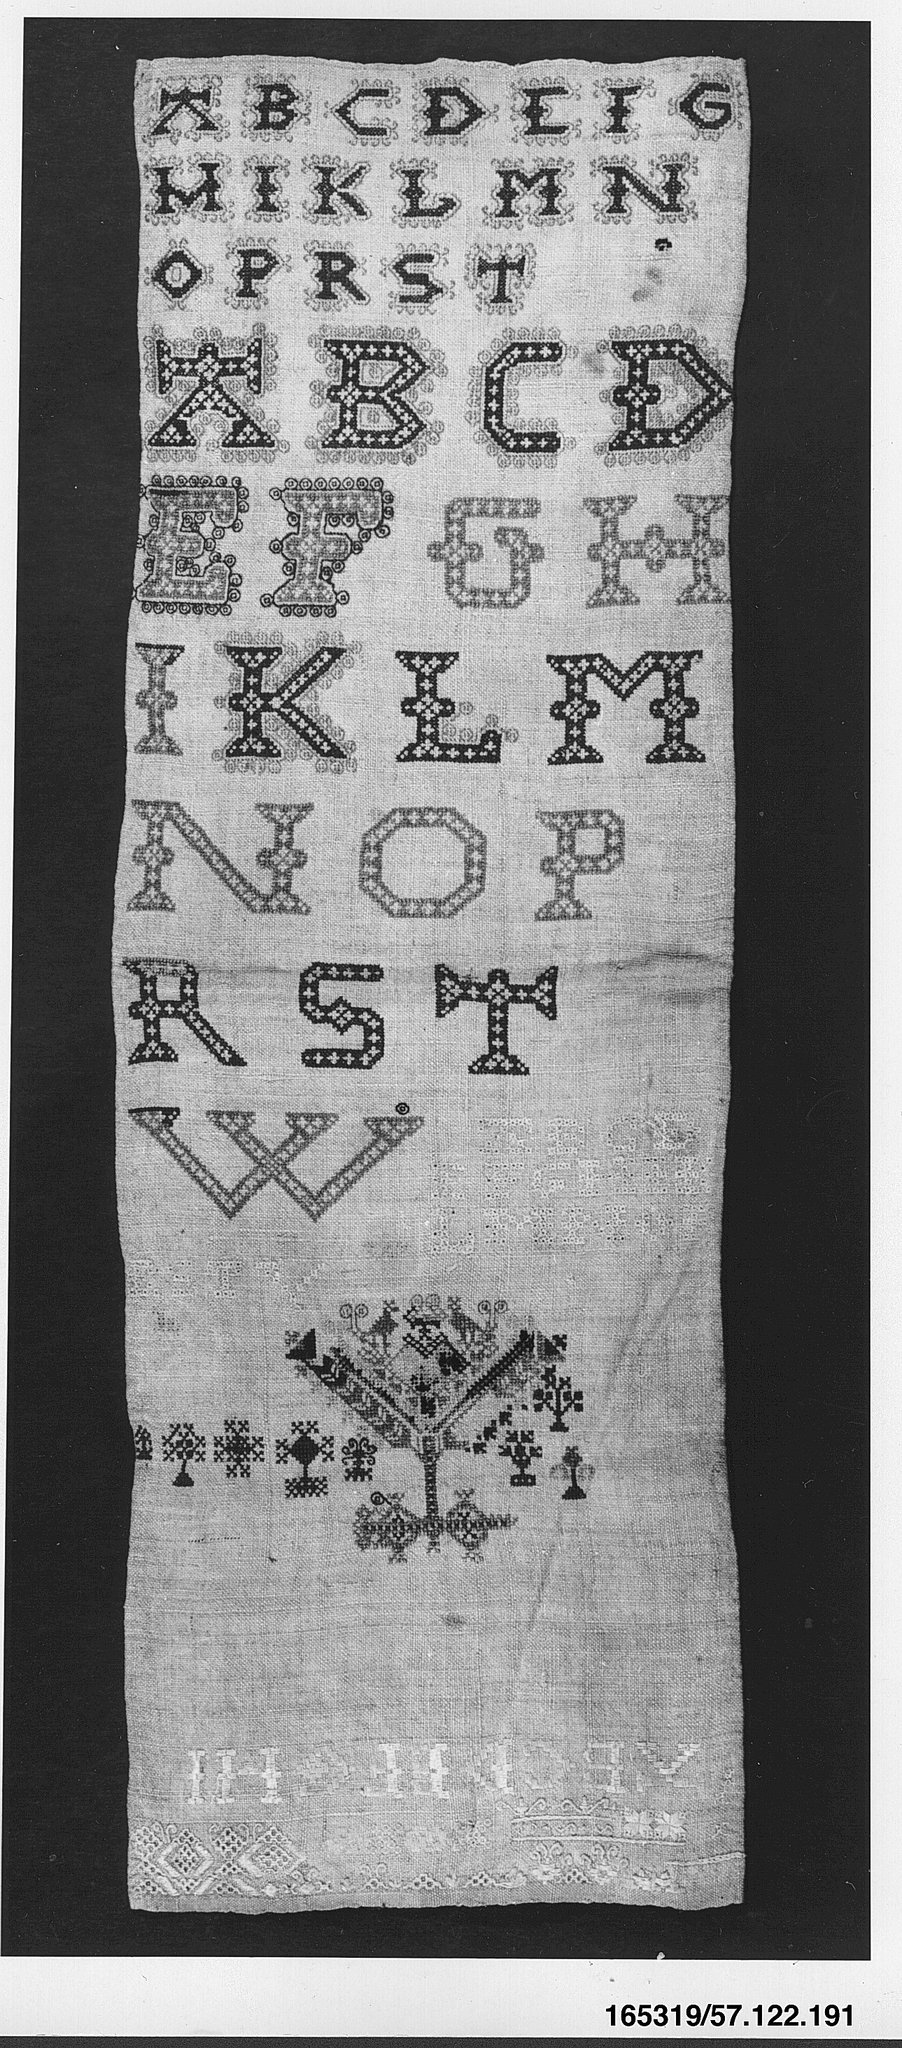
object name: sampler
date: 1701-1800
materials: linen, silk